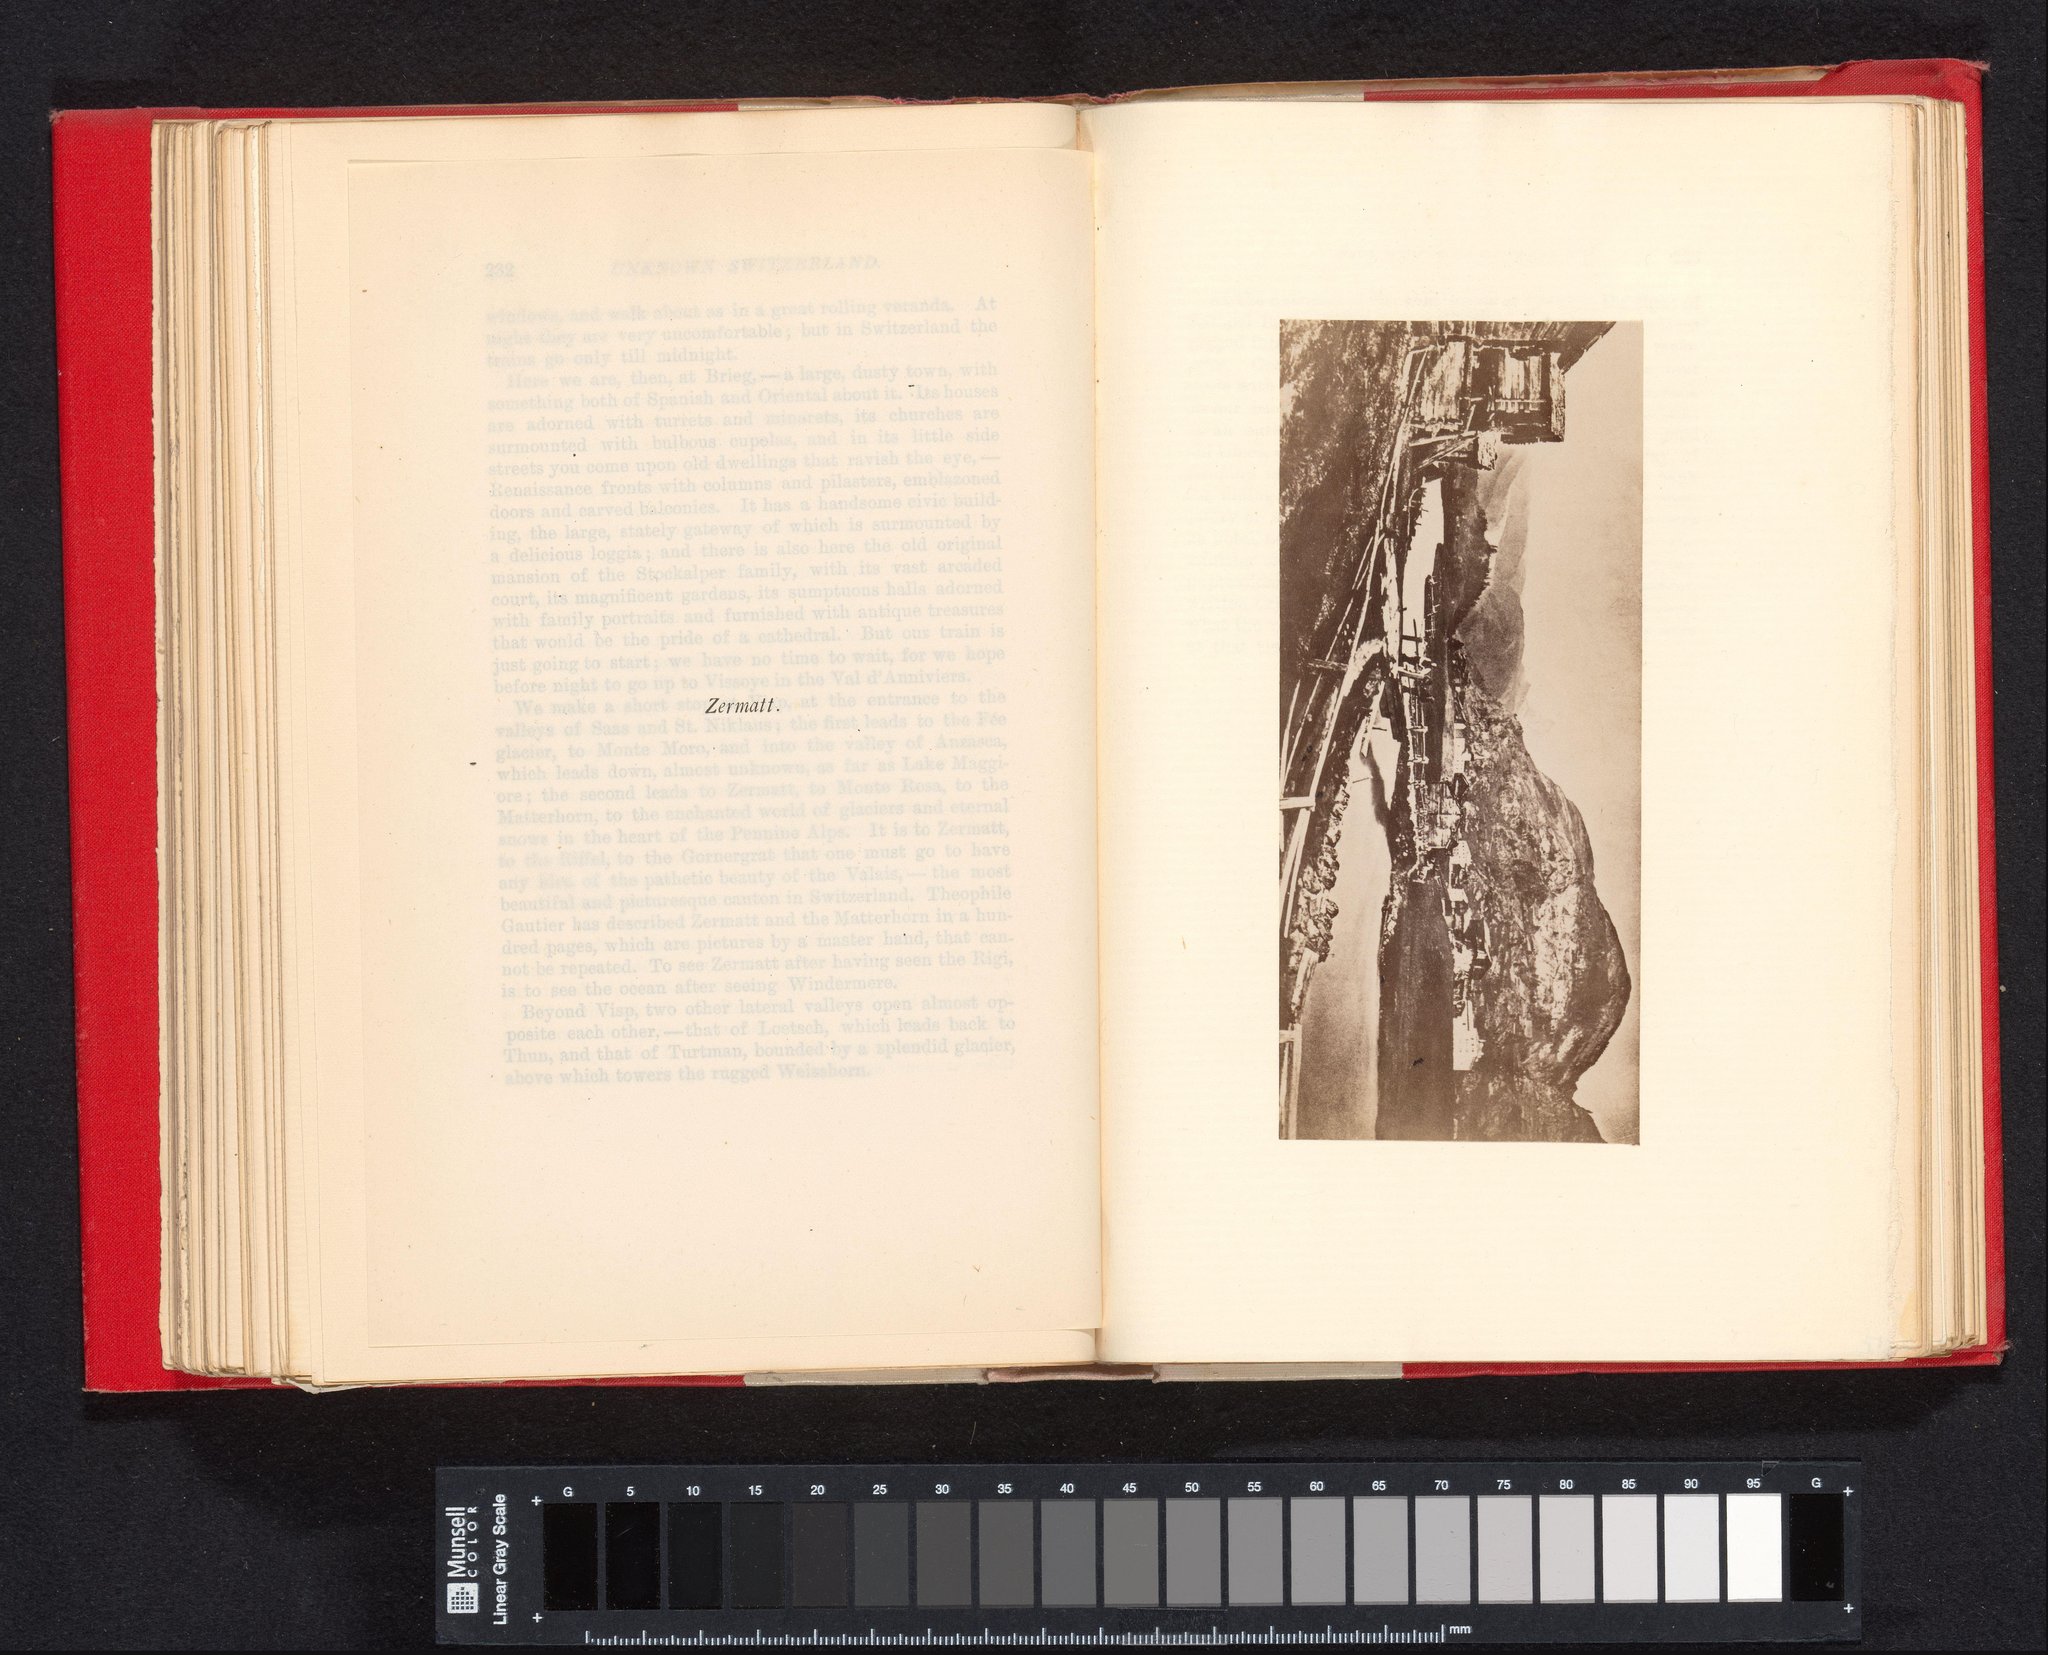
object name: photograph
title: Gezicht op Zermatt in Zwitserland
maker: Anonymous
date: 1879-1889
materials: photographic support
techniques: albumen print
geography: wallis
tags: city-view, and landscape with man-made constructions, river